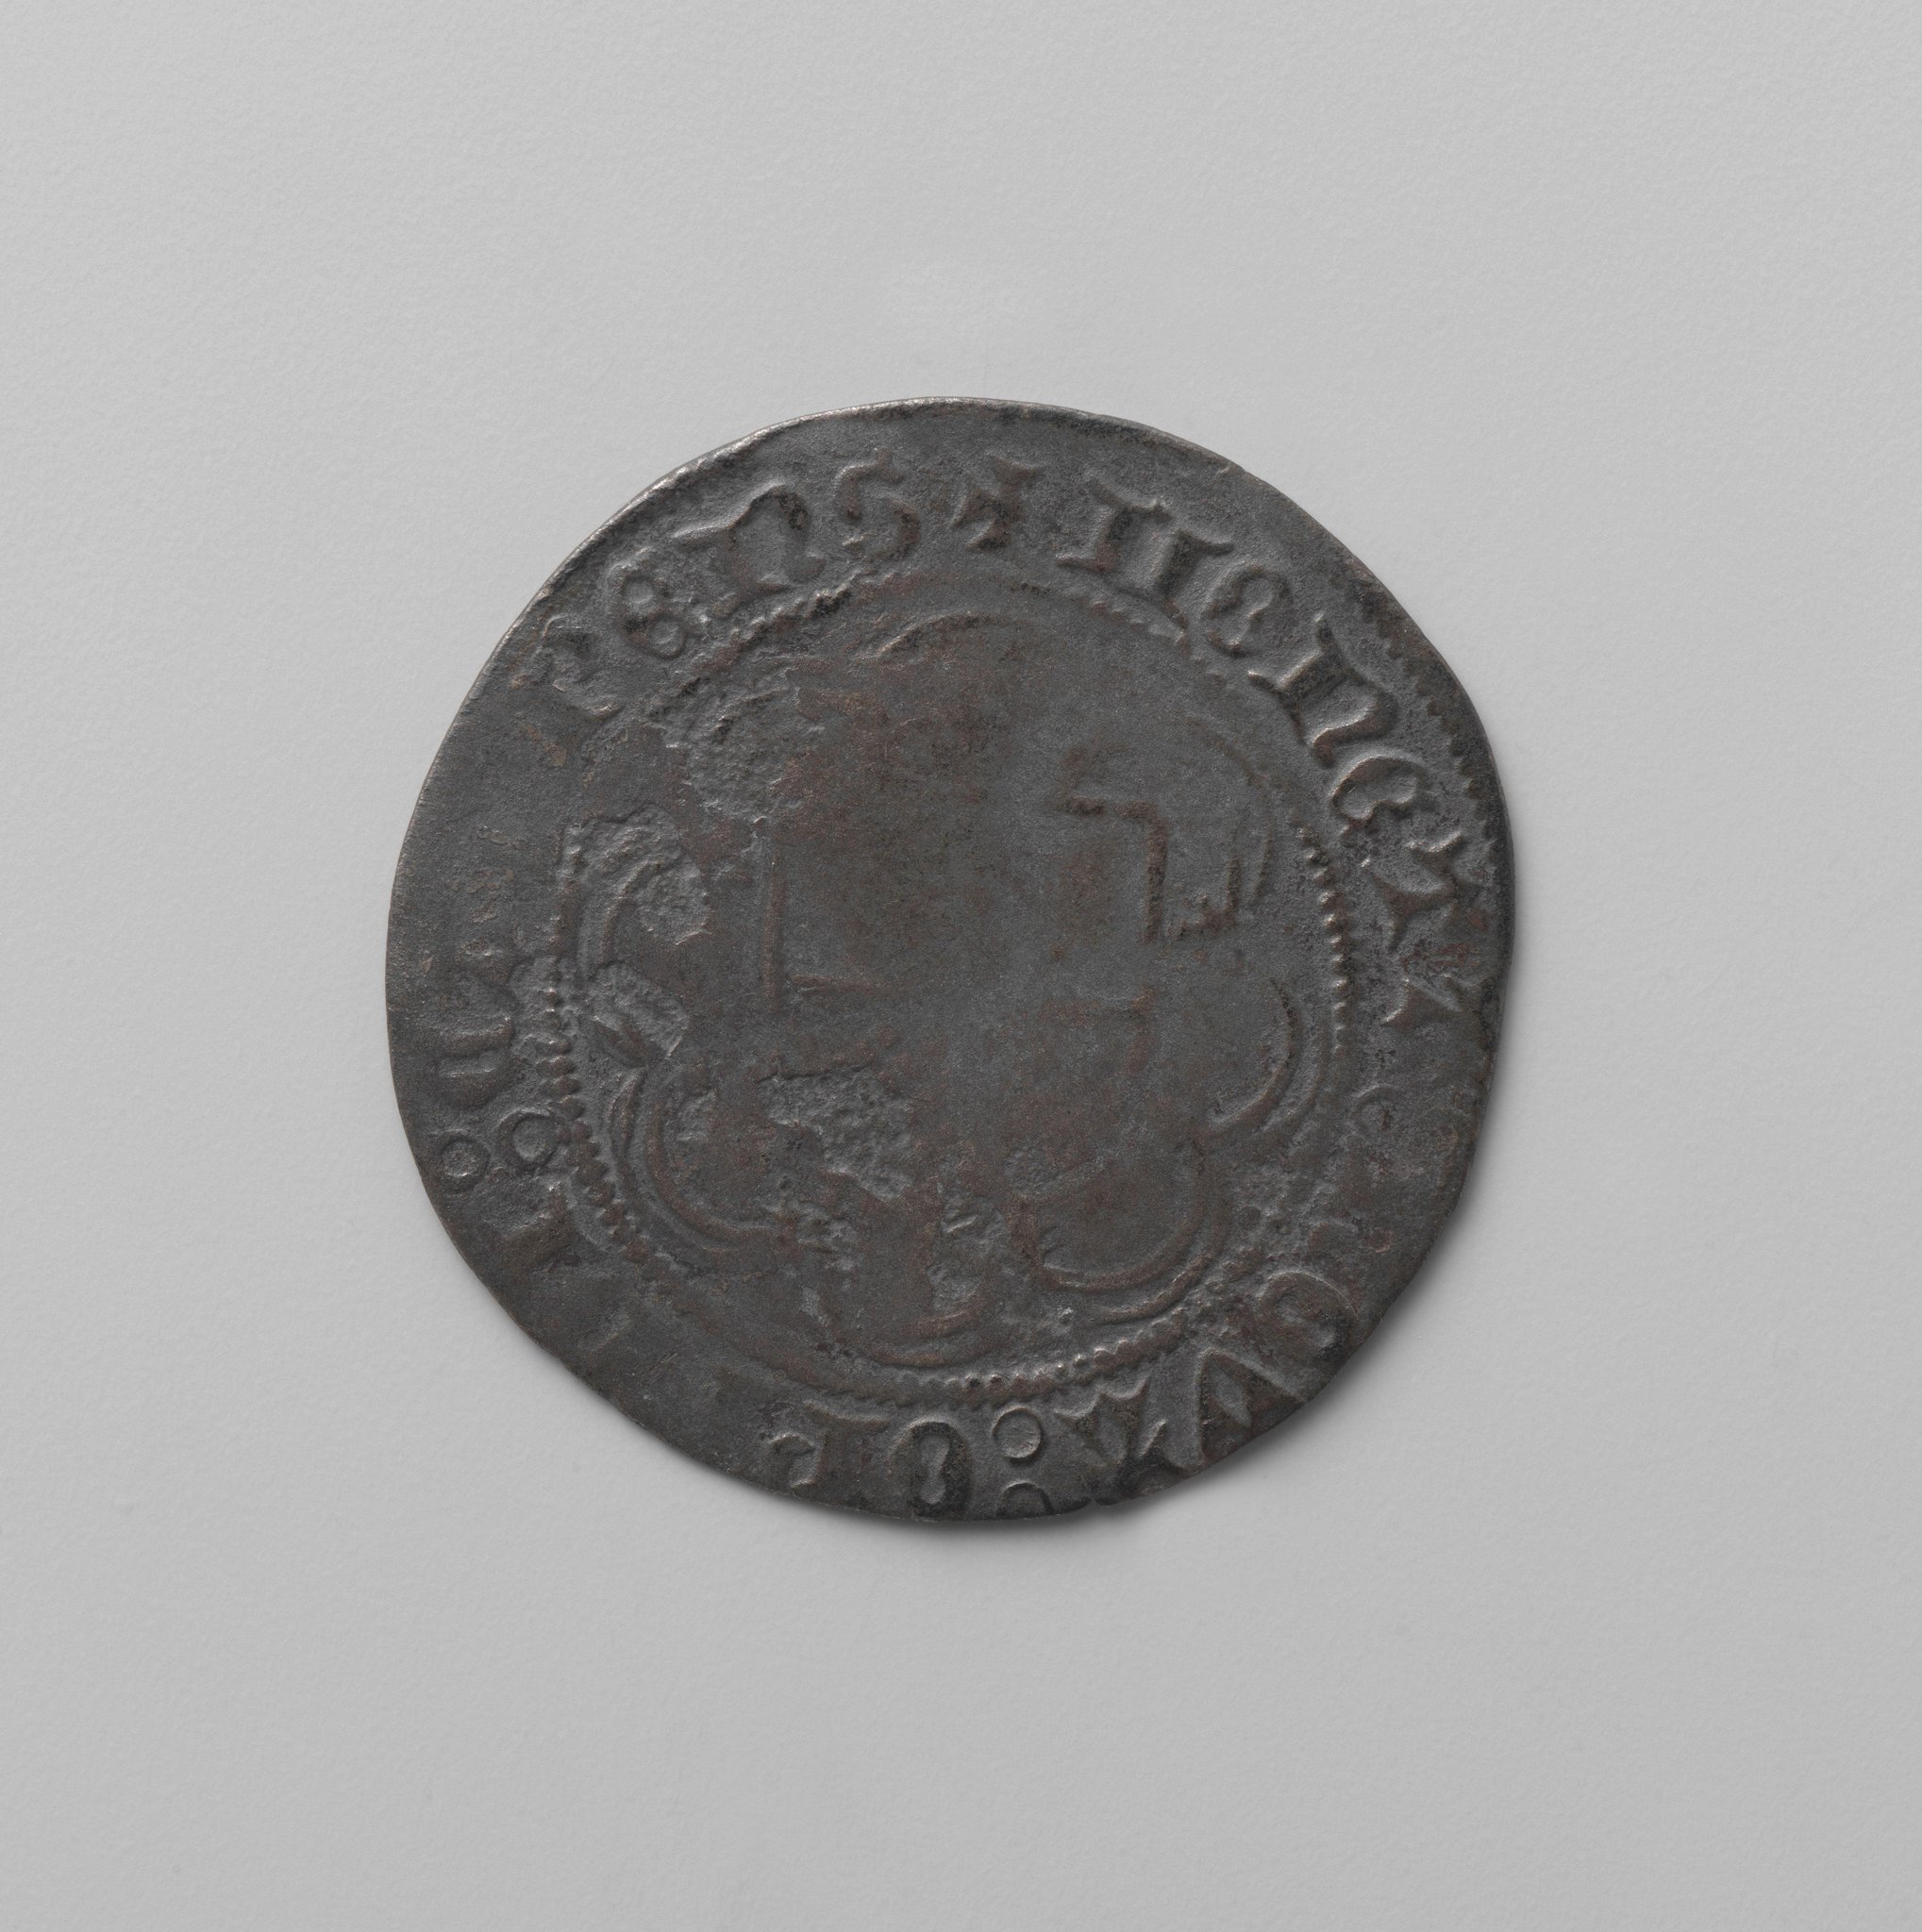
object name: coin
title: Kampen, Kromstaart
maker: Anonymous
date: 1450-1475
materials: silver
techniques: striking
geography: kampen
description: Zilveren munt. Voorzijde: binnen dubbellijnige achtpas wapenschild van Oversticht. Keerzijde: kort gevoet kruis, in de hoeken letters C, A, M en P.